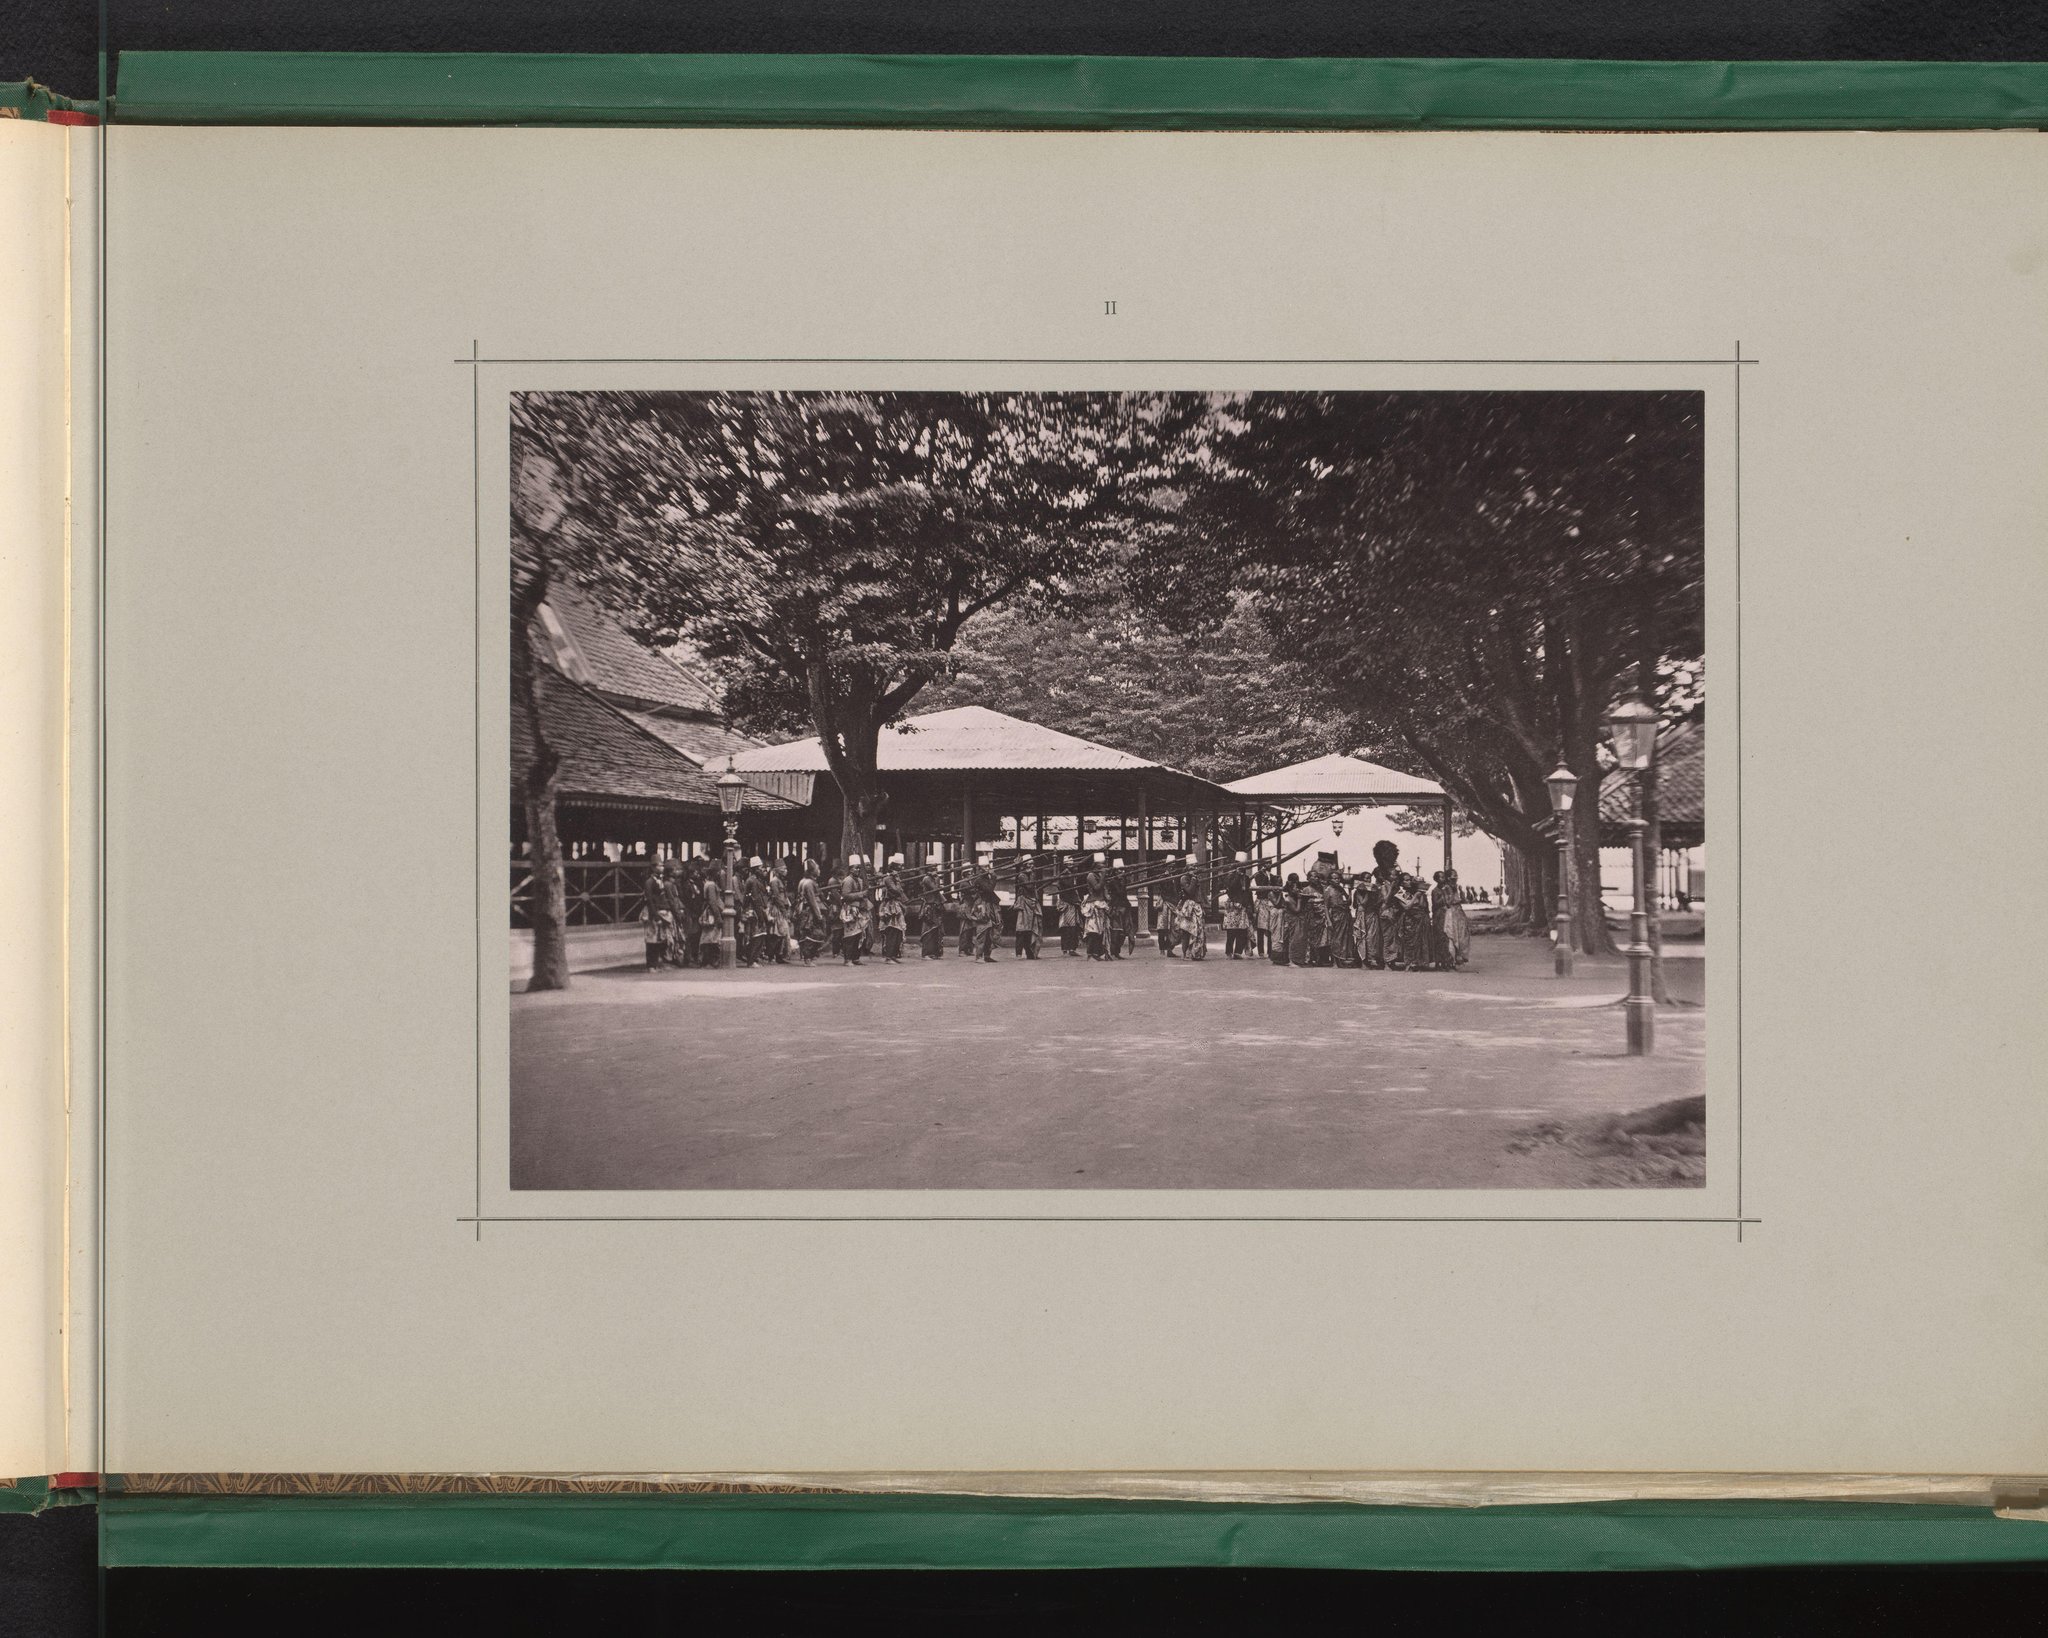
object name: page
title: Groep dragers van erfstukken in de Kraton Ngayogyakarta Hadiningrat in Jogyakarta, Indonesië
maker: kassian céphas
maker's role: fotograaf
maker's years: 1845-1912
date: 1883-1888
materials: paper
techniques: photograph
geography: yogyakarta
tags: adult woman (+ more than eight persons), adult man (+ more than eight persons), heirloom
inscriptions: number: ‘II’